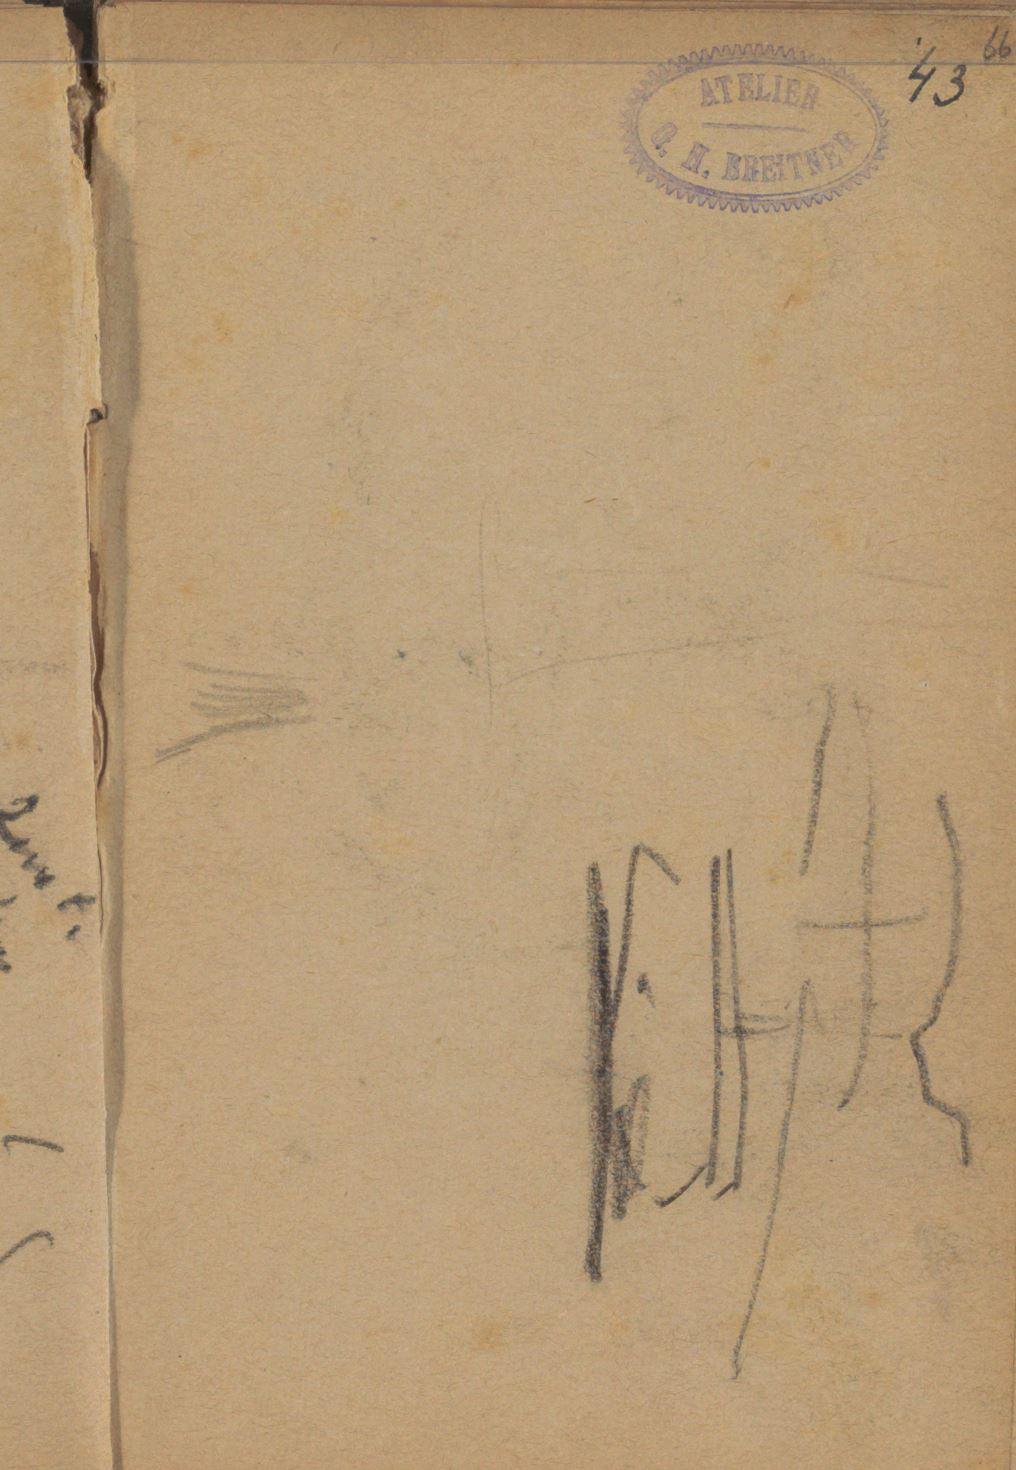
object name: sketchbook leaf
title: Studie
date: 1887-1891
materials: chalk, paper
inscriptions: workshop stamp: Lugt 291d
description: Pagina 66 uit een schetsboek met 83 bladen.